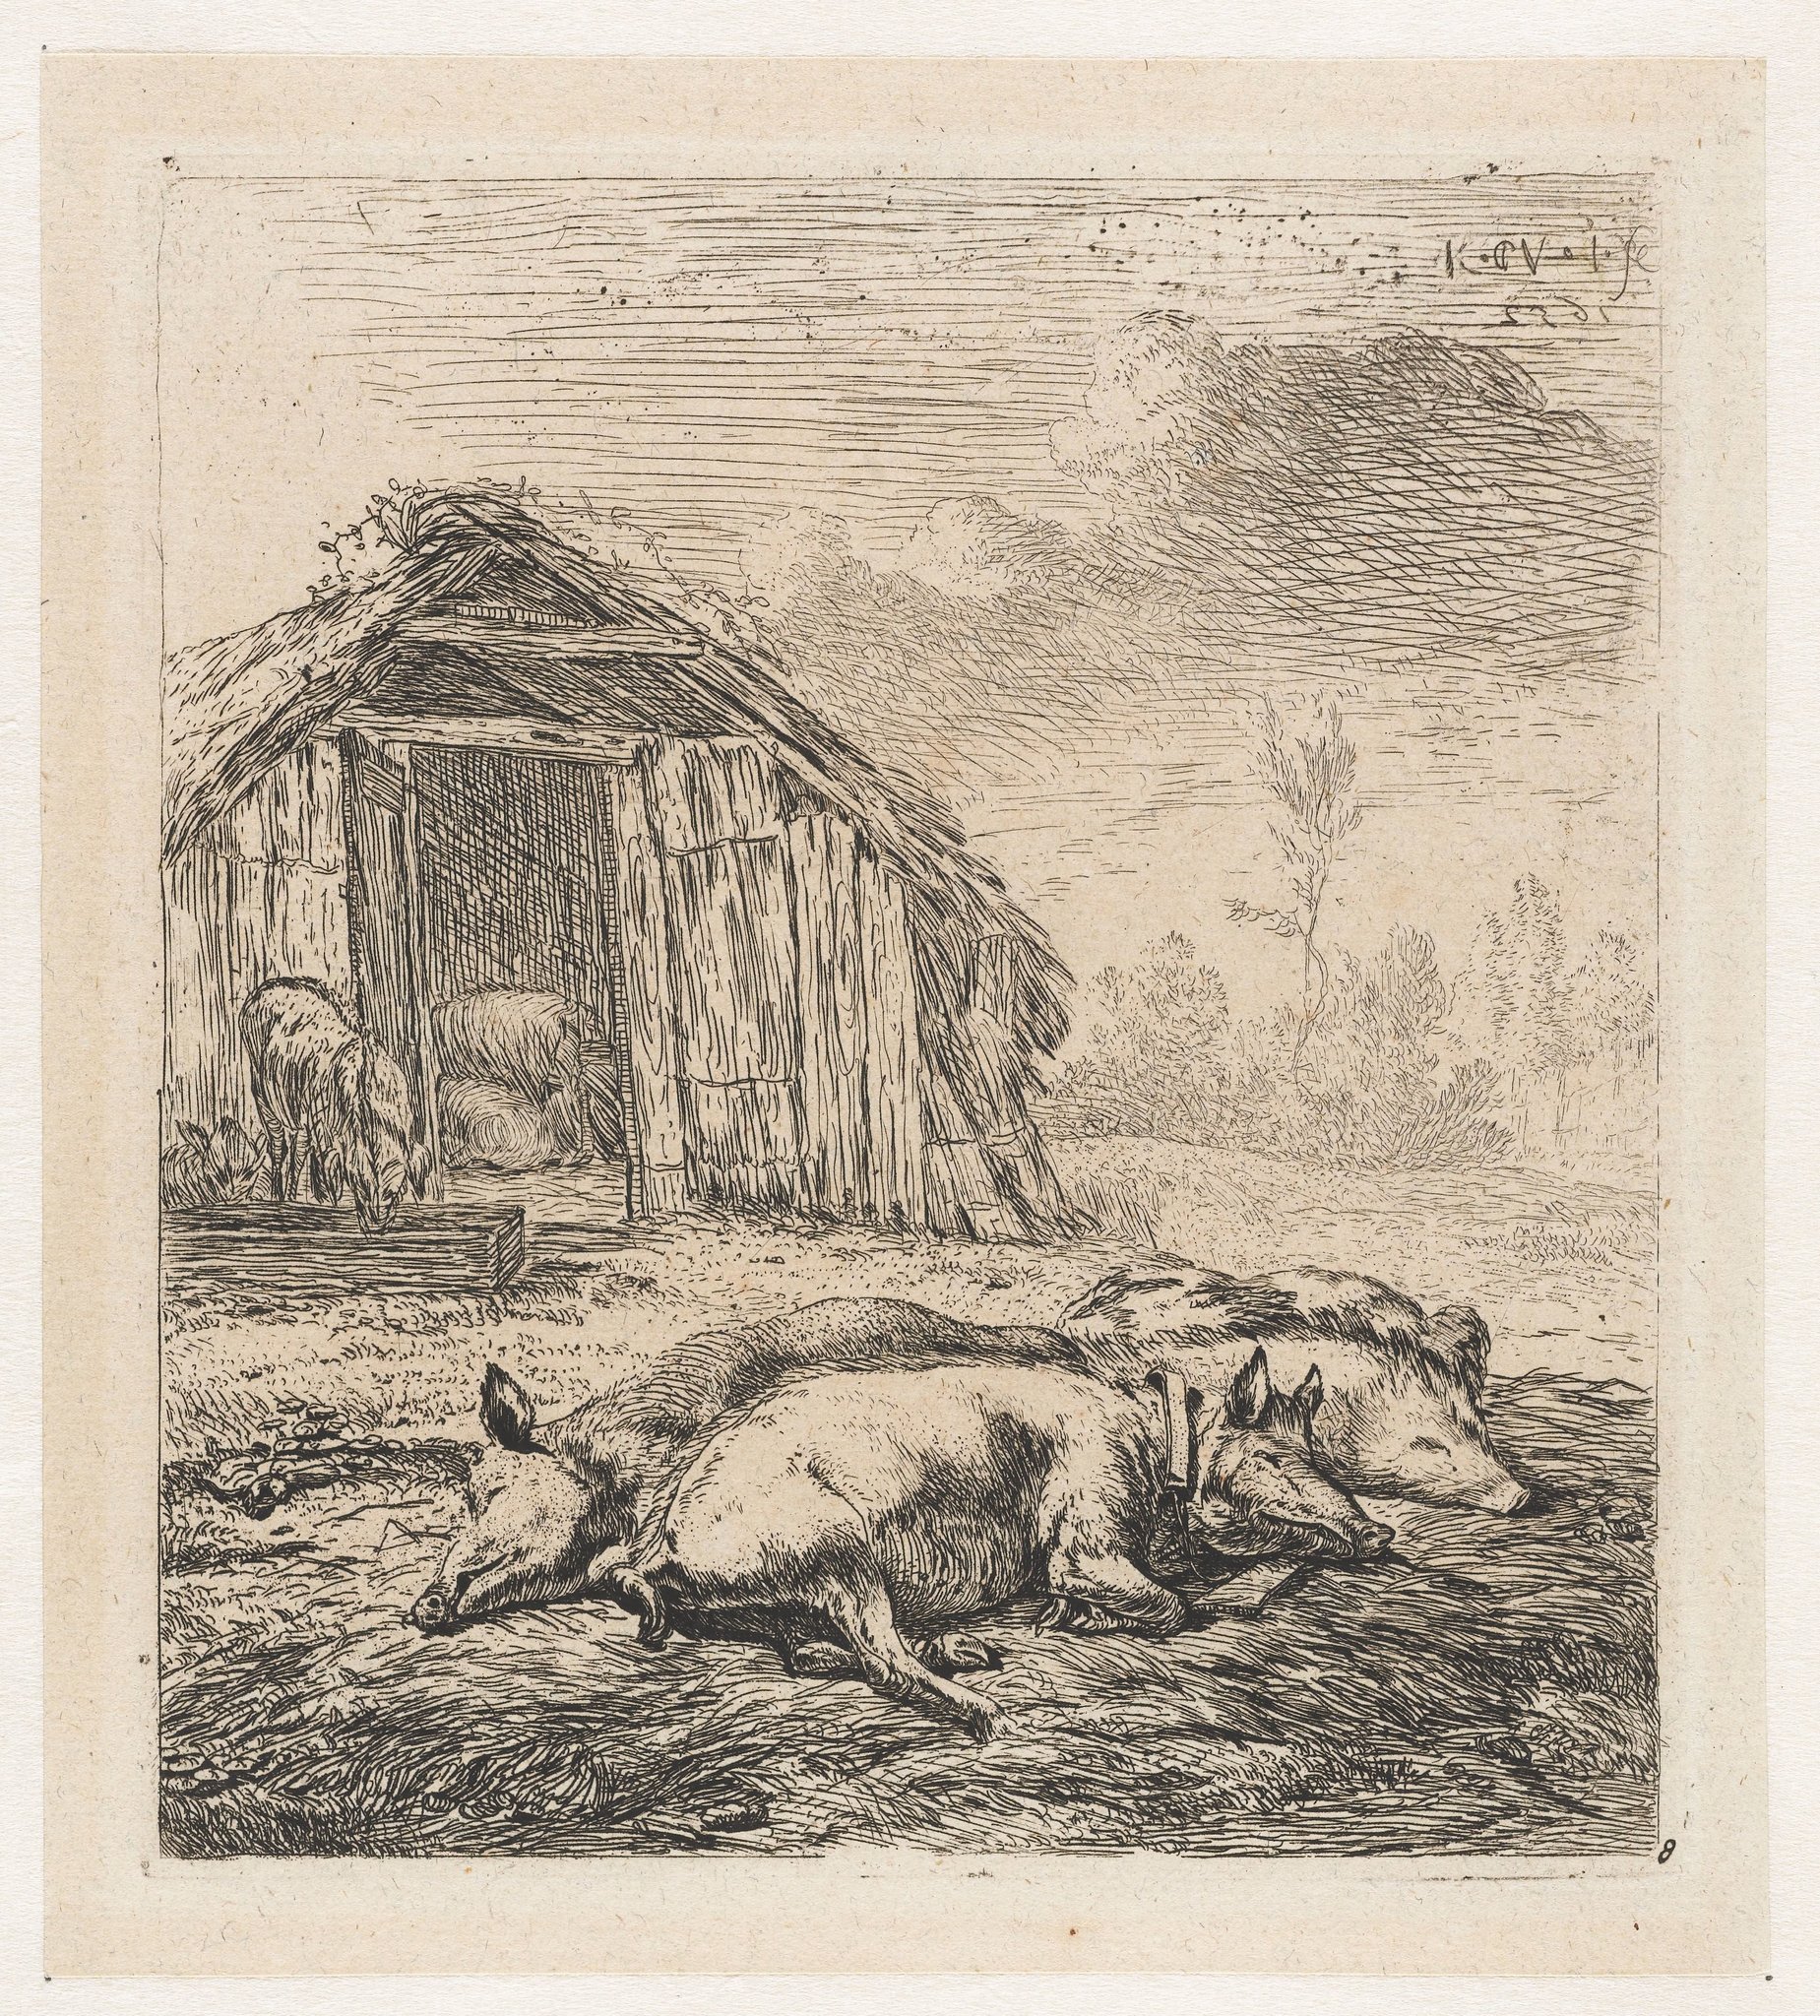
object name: print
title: Dieren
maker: karel du jardin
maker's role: draughtsman, painter, print maker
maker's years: 1626-1678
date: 1652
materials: paper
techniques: etching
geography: amsterdam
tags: pig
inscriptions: date